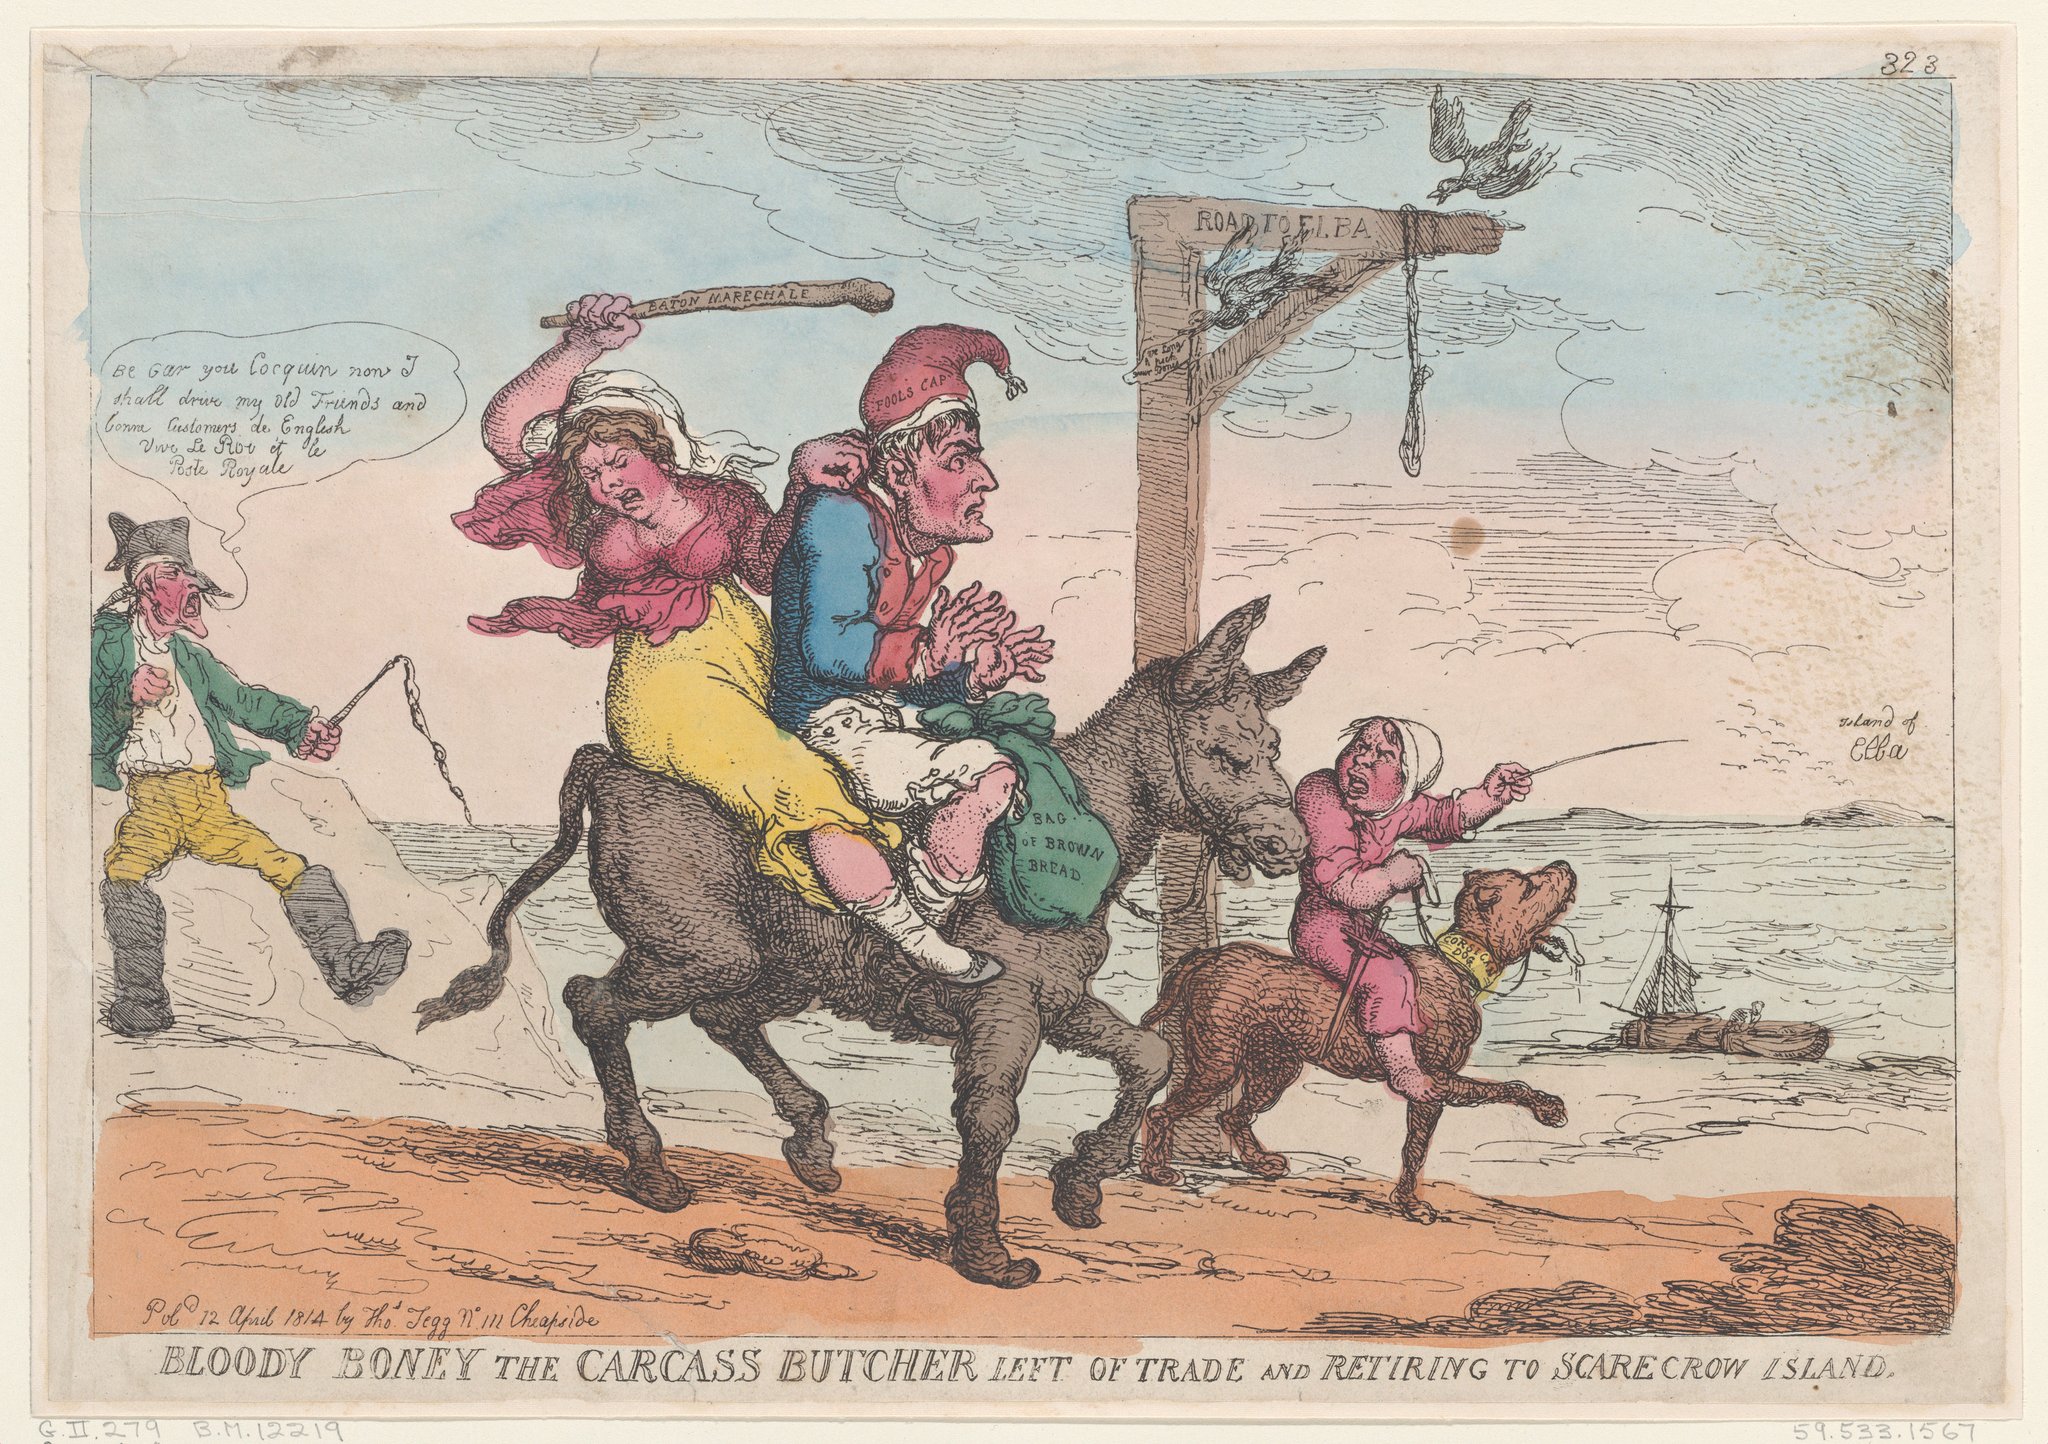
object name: print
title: Bloody Boney the Carcass Butcher Left of Trade and Retiring to Scarecrow Island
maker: thomas rowlandson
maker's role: artist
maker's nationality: british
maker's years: 1757-1827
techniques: etching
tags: satire,napoleon i,men,women,dogs,donkeys